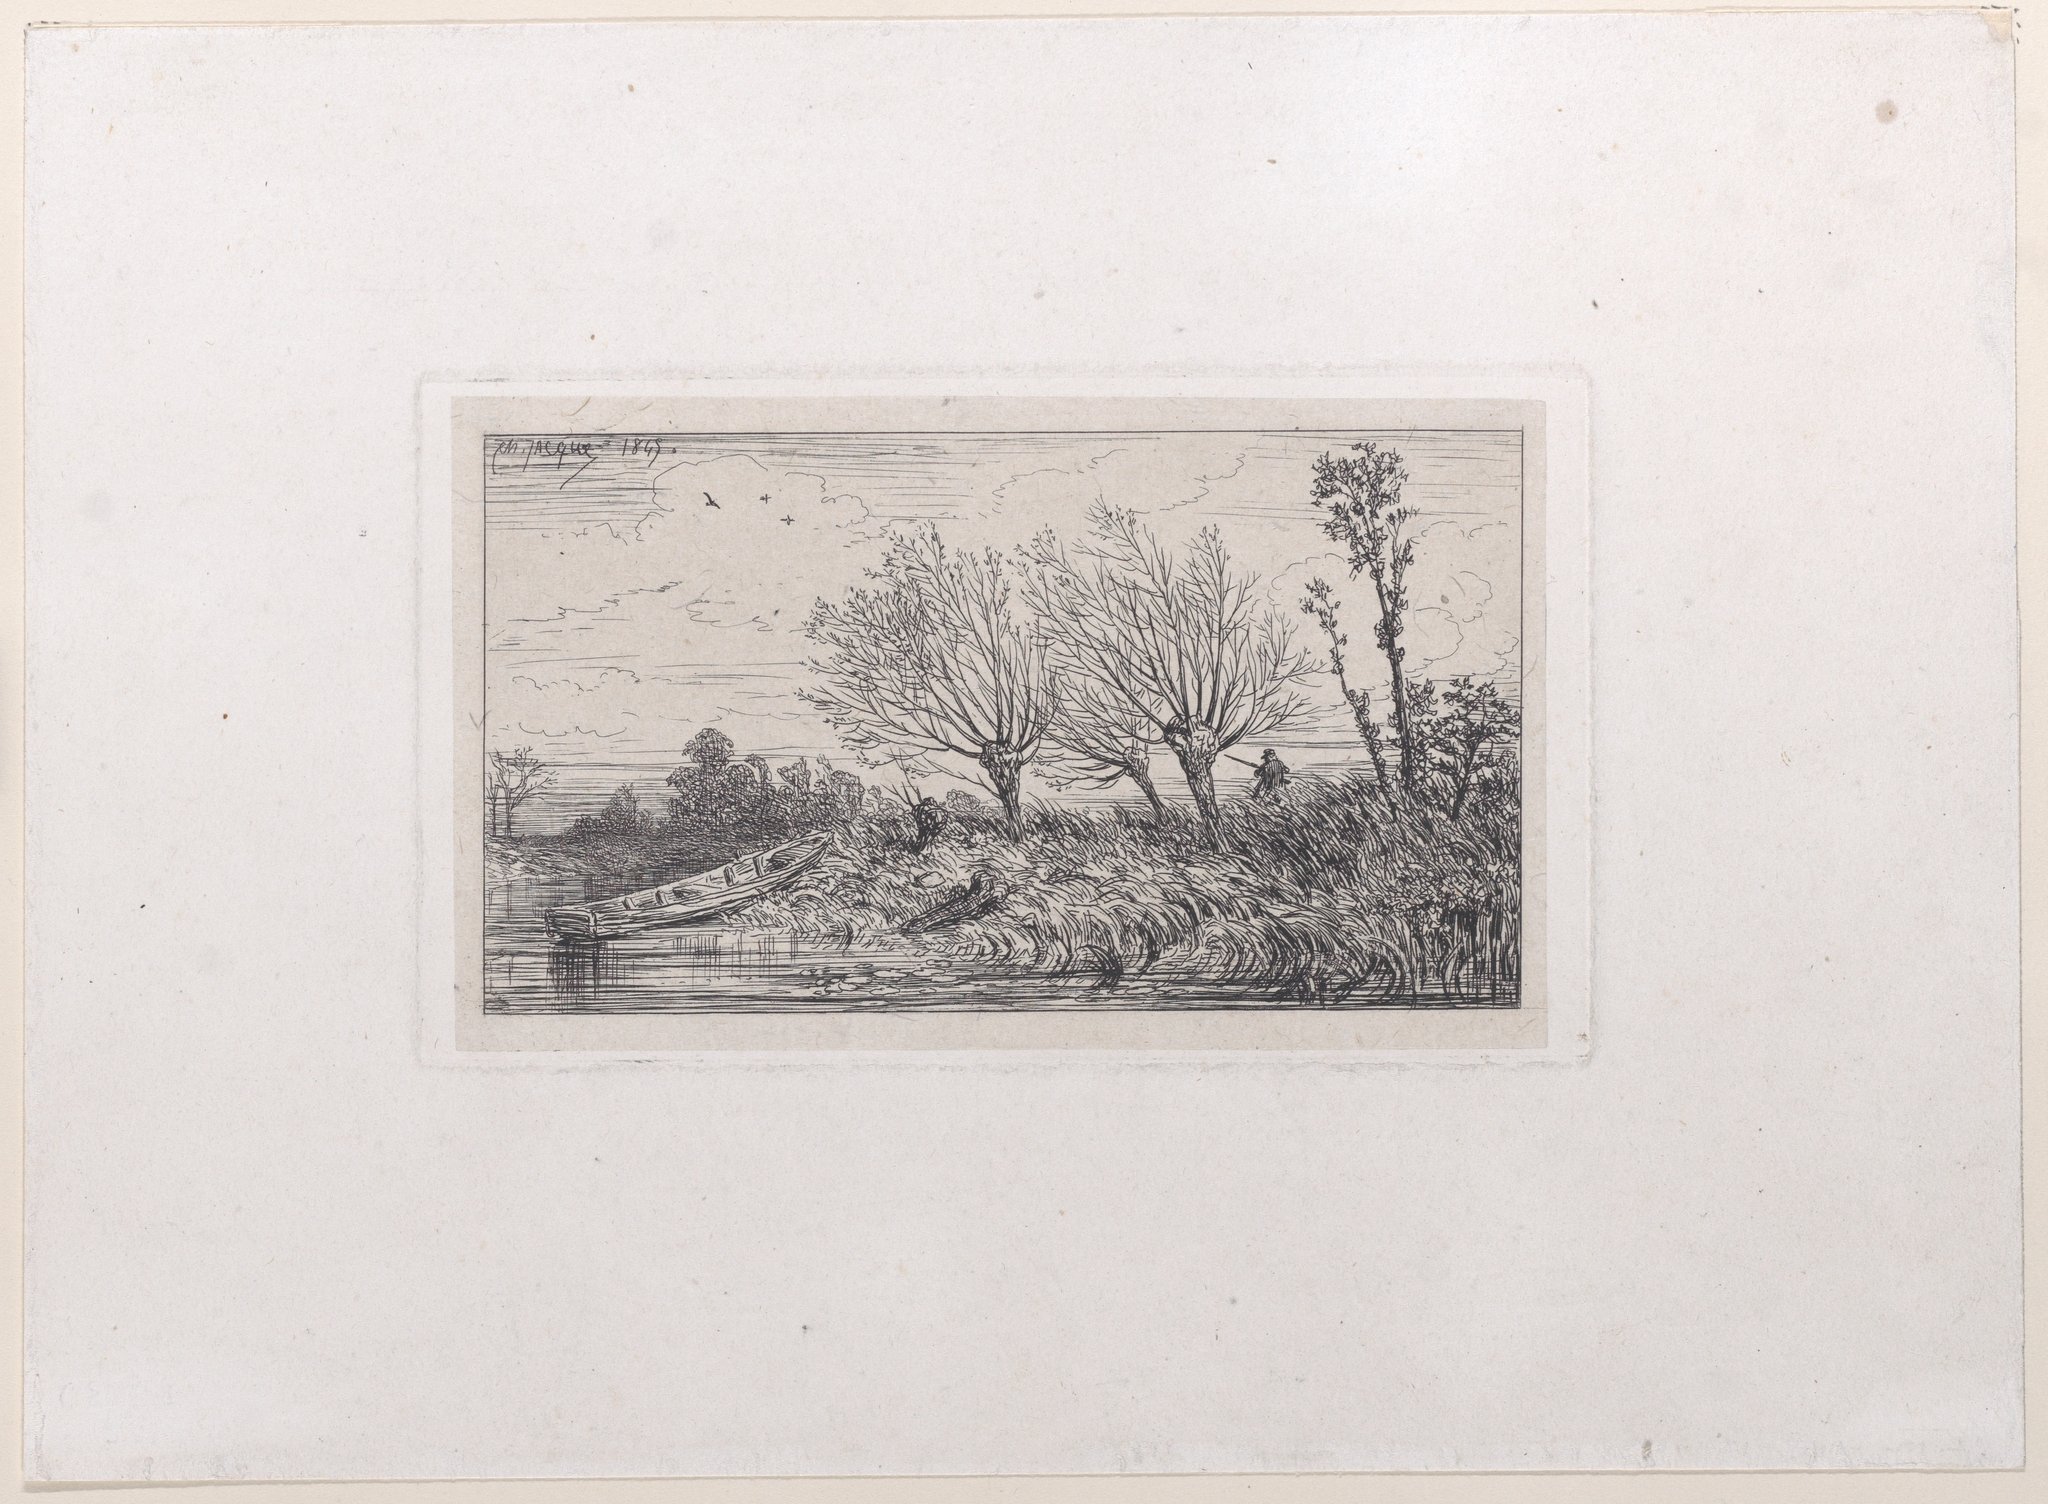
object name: print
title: Landscape with Willow Trees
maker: charles émile jacque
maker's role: artist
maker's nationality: french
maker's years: 1813-1894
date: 1845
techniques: etching